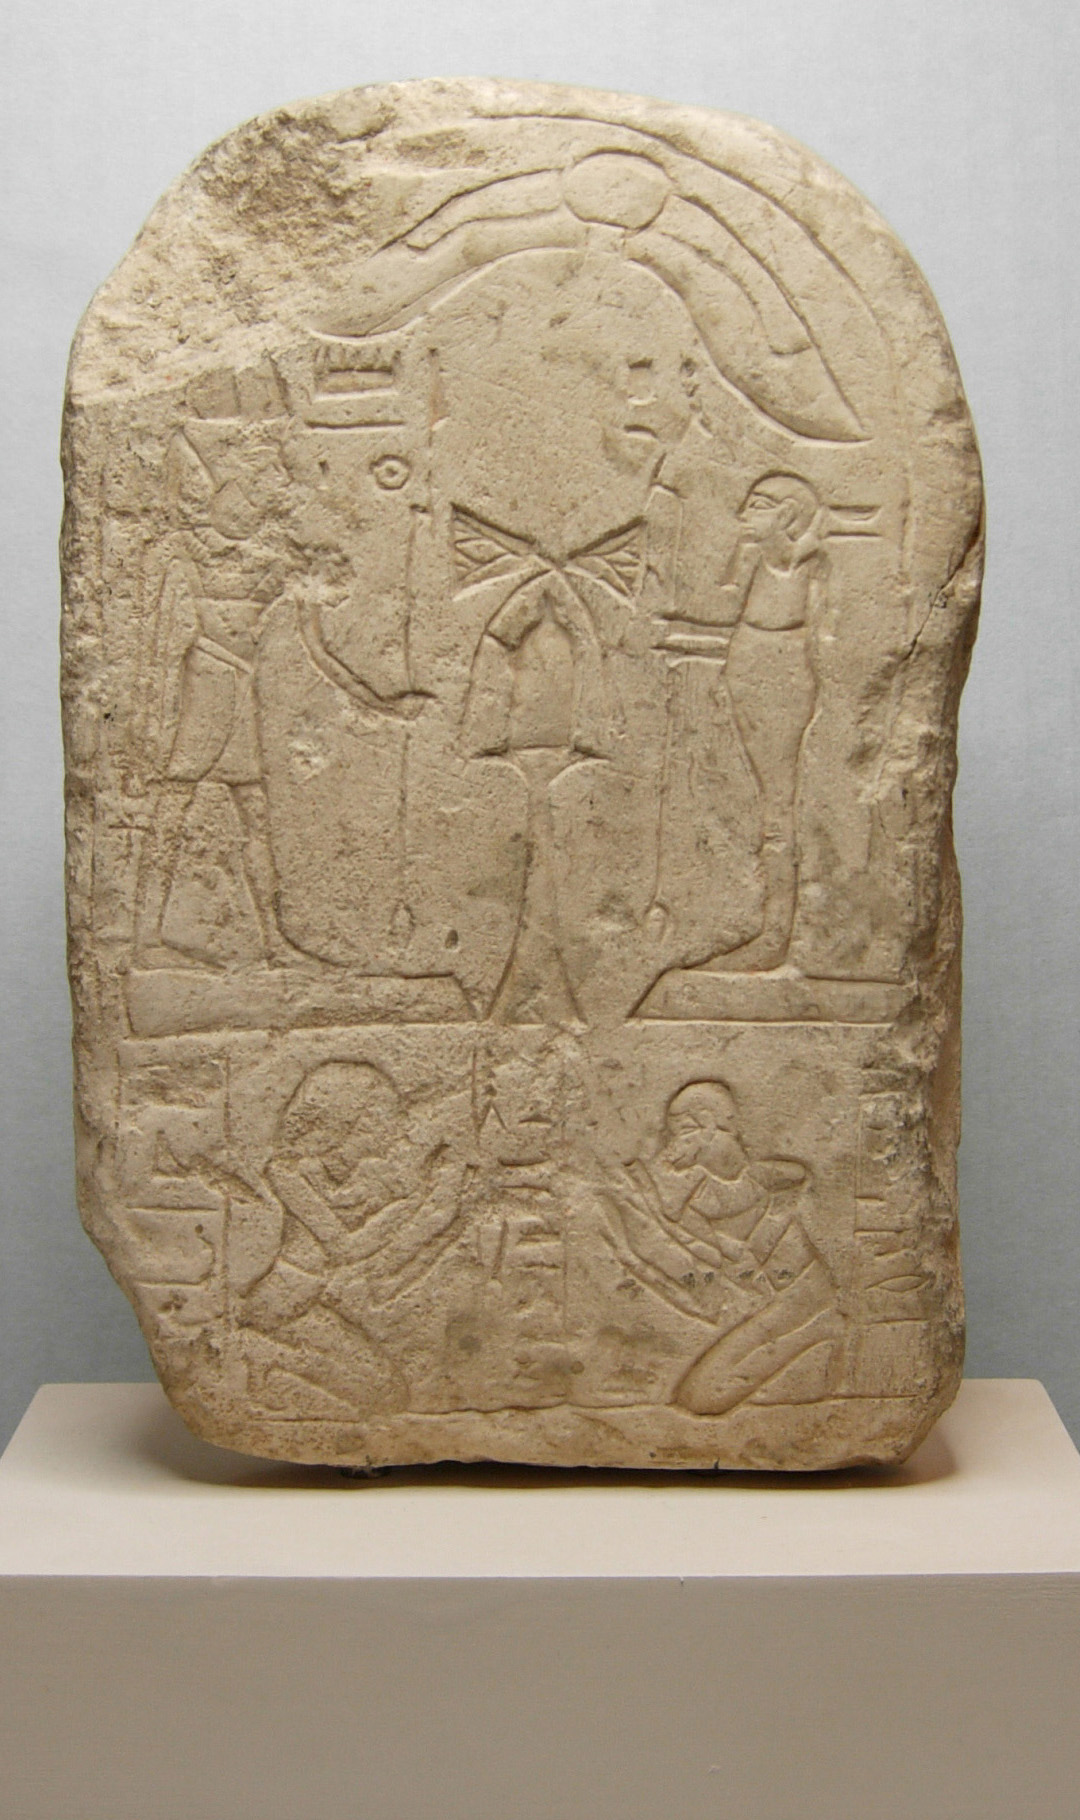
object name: stela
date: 1550-1295 BCE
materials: limestone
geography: egypt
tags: human figures